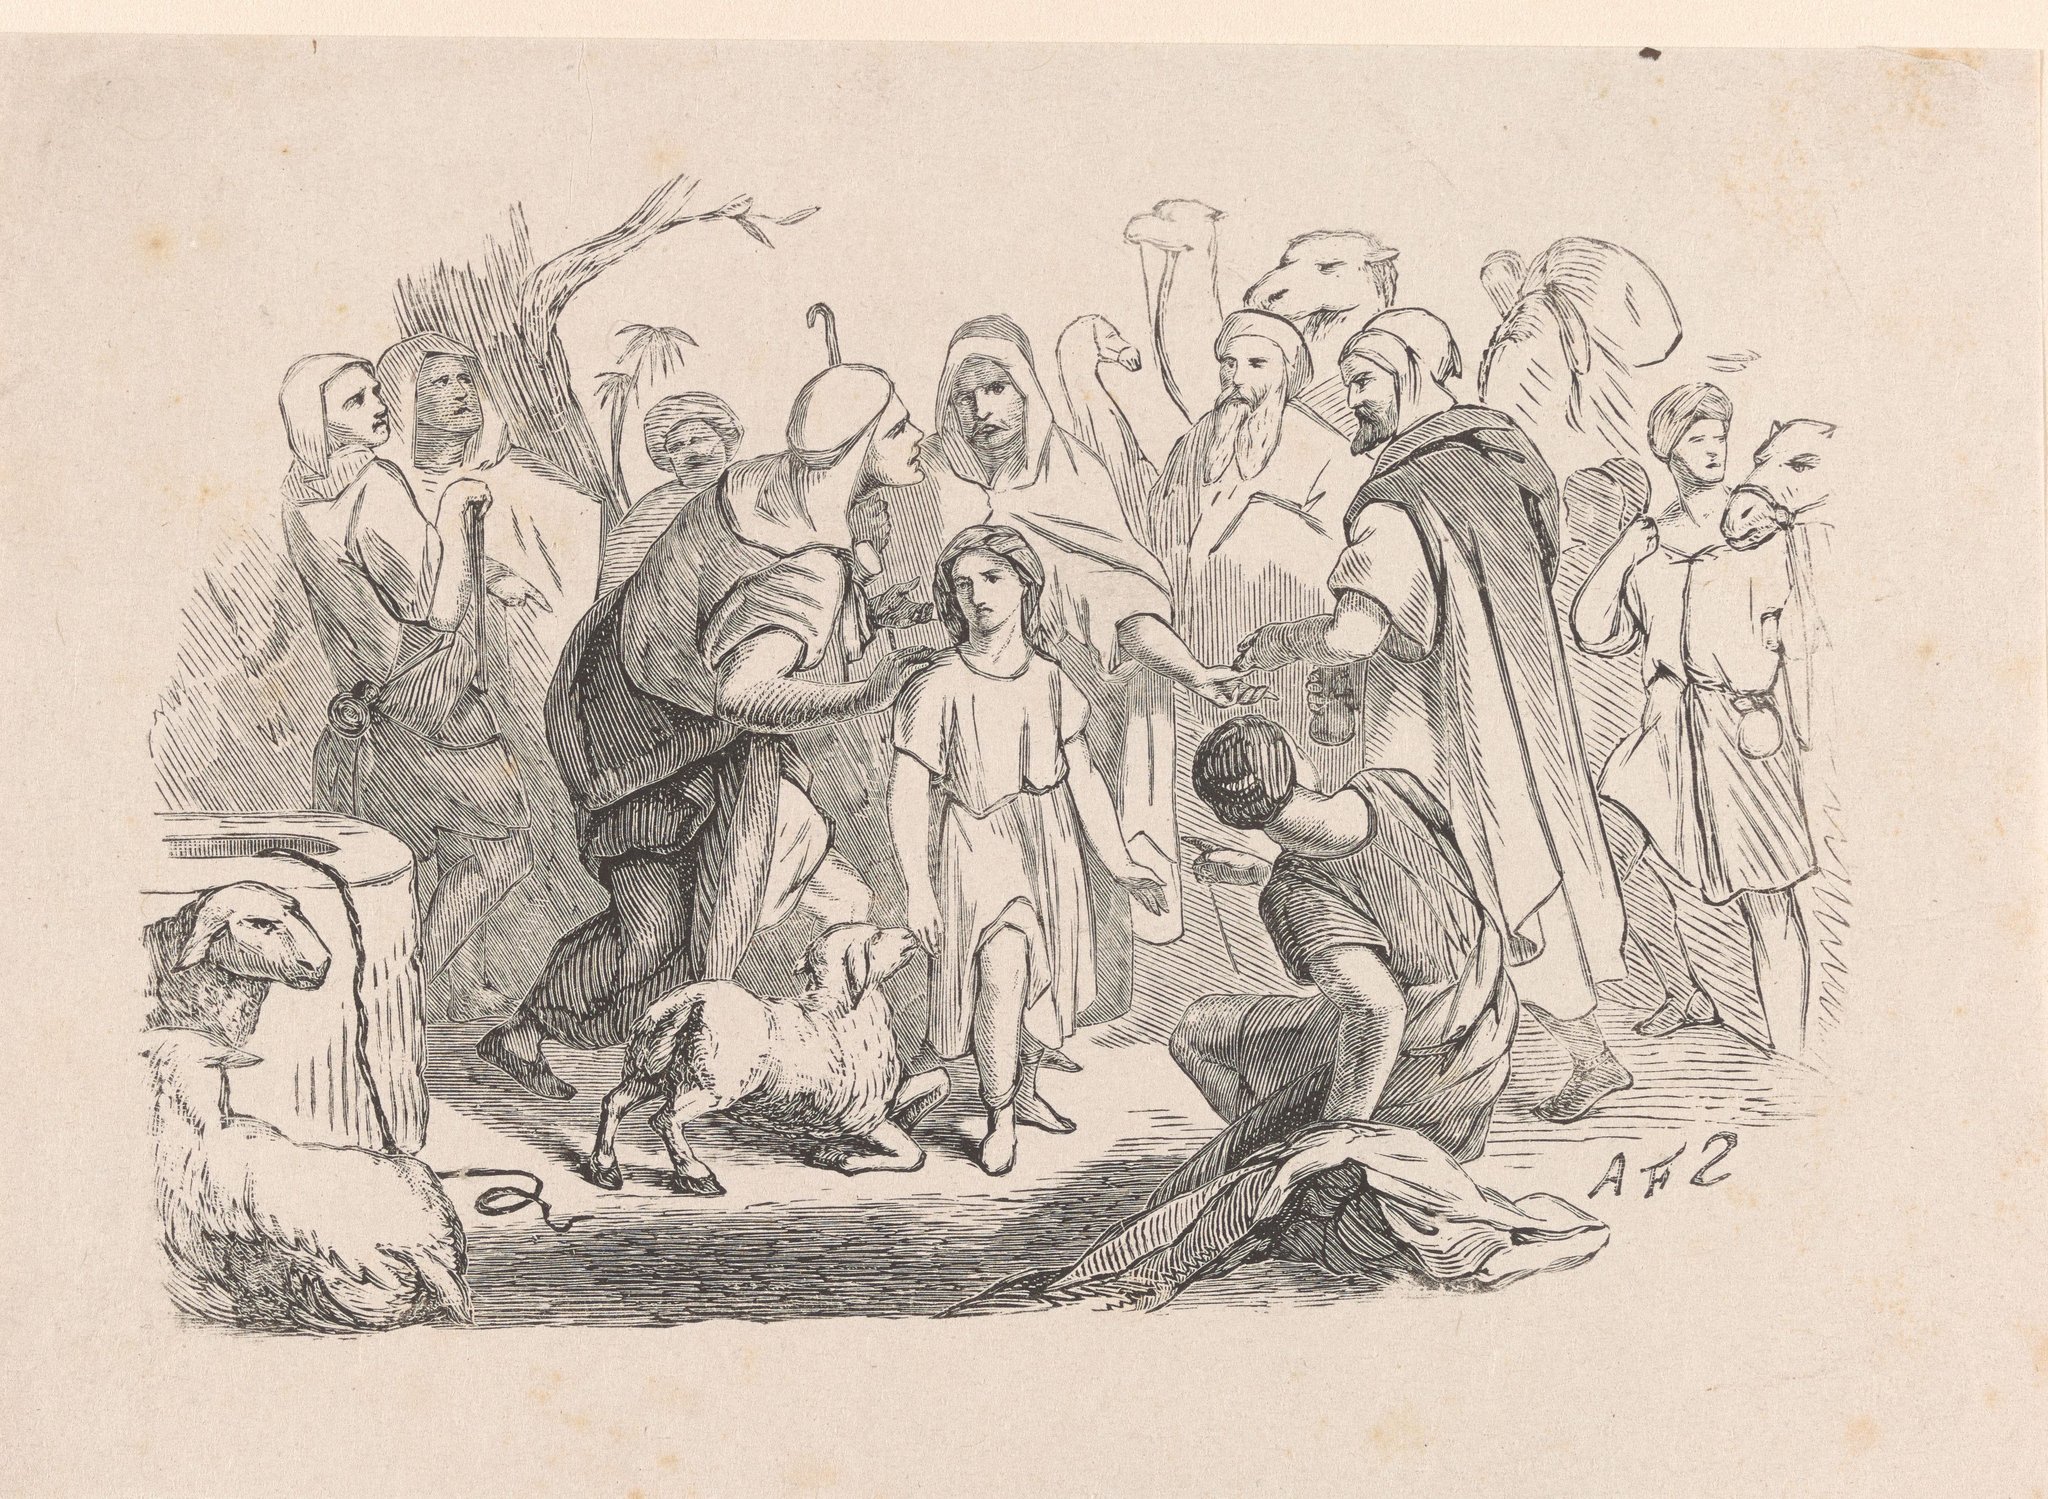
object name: print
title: Groep herders met schapen en kamelen bij een put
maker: isaac weissenbruch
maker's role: print maker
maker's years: 1826-1912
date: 1836-1912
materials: paper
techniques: engraving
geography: netherlands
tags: hoofed animals: camel, well, herding, herdsman, herdswoman, shepherd, shepherdess, cowherd, etc., sheep